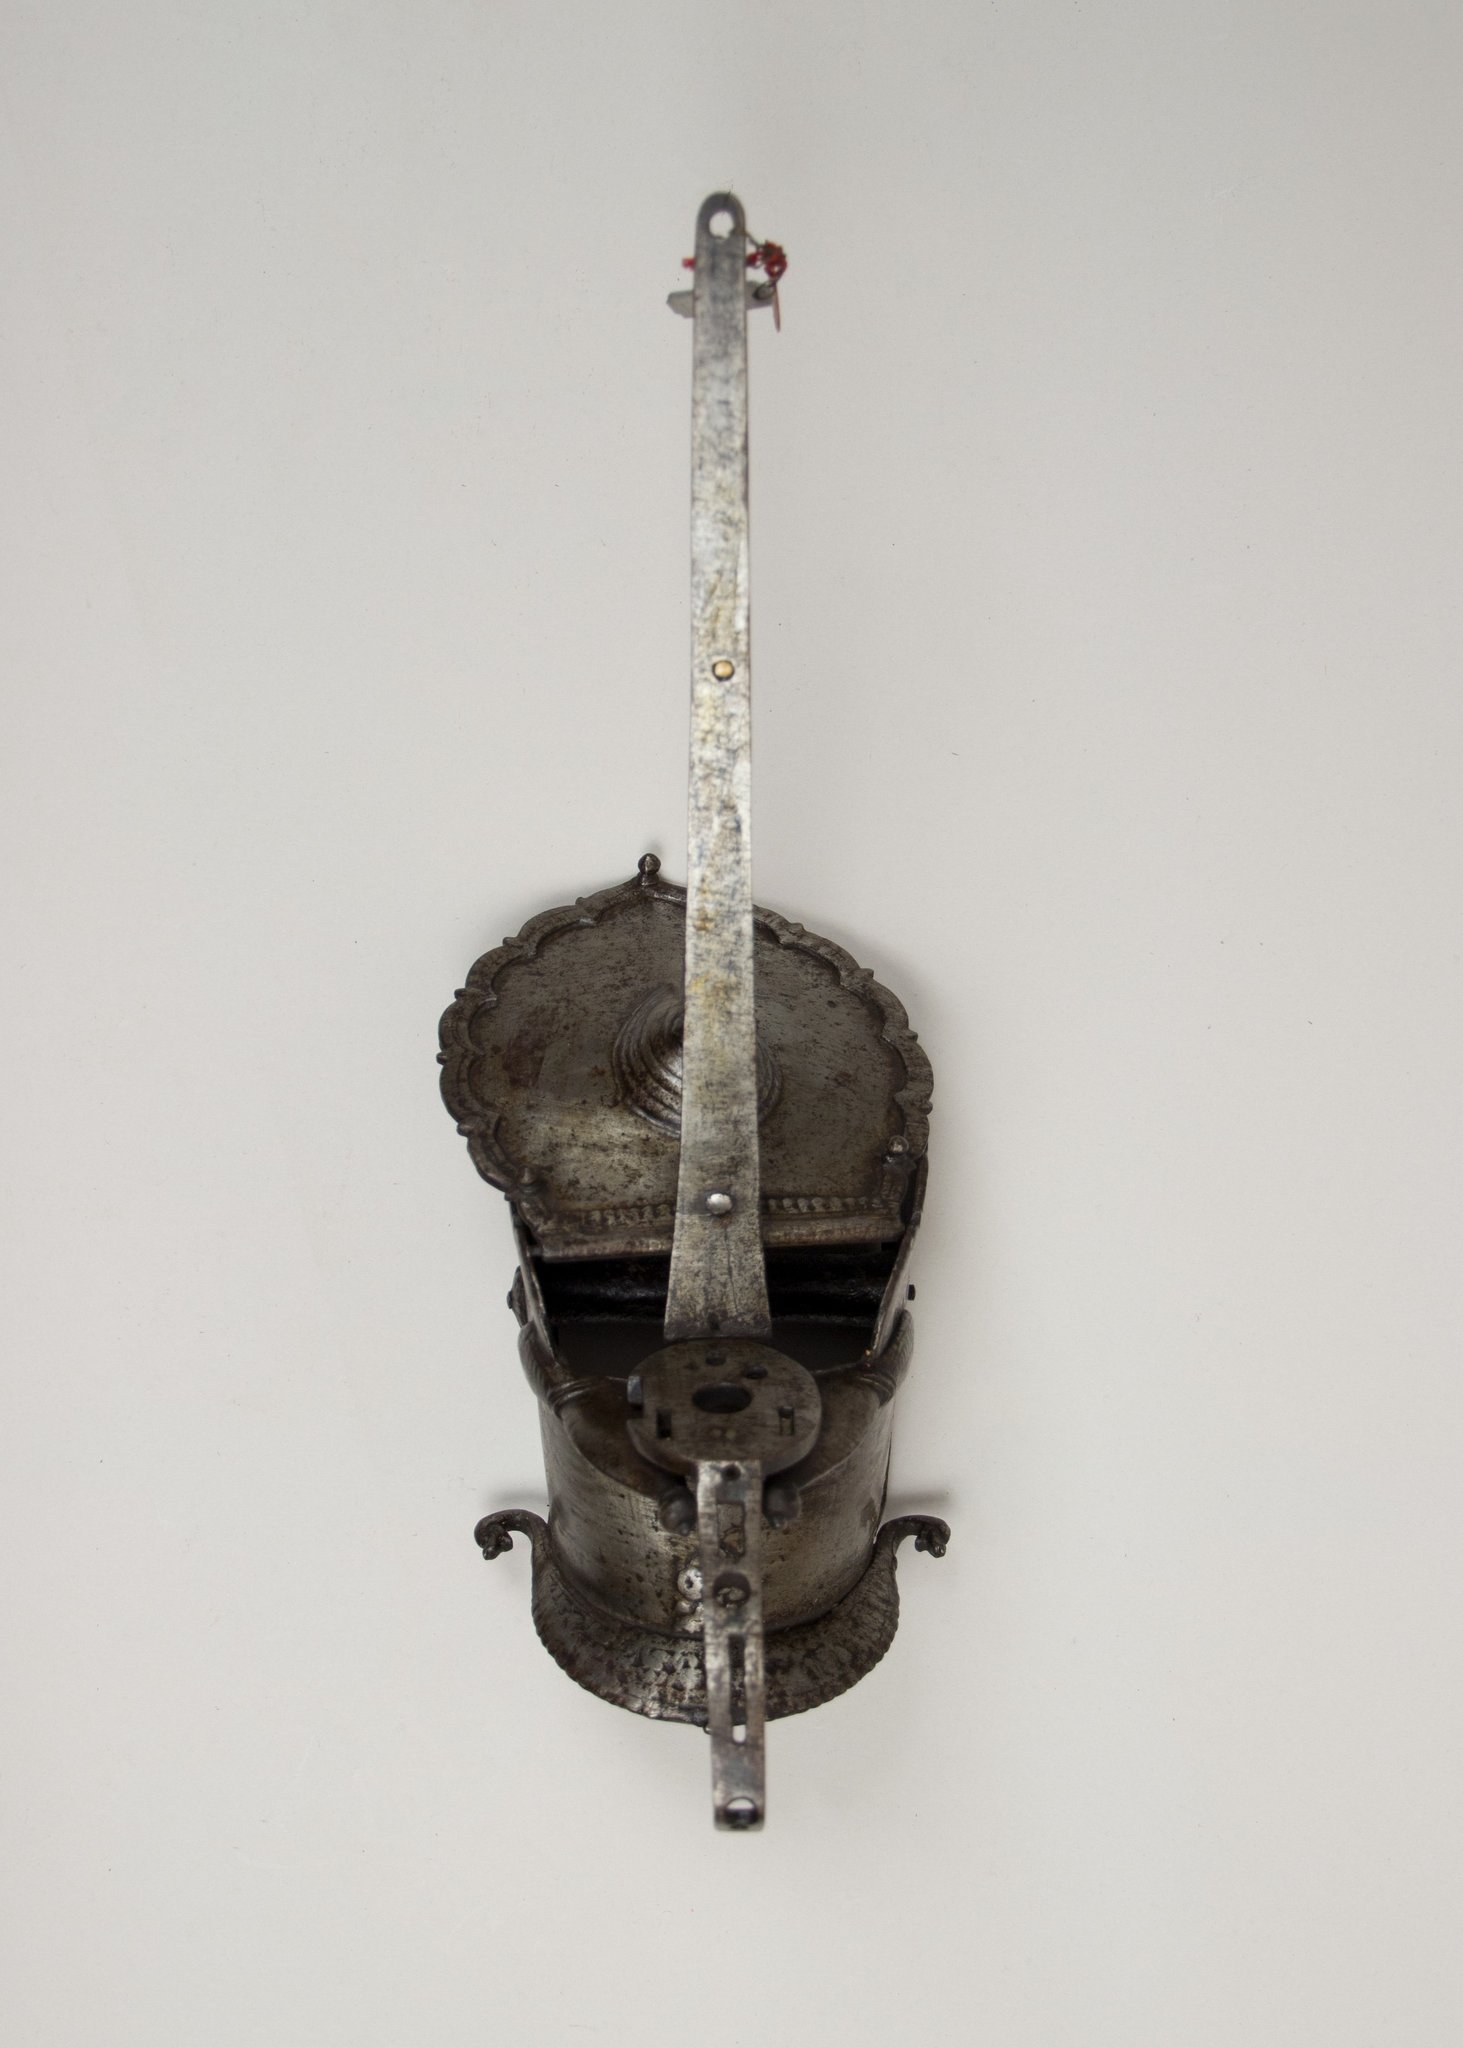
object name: hilt of a gauntlet sword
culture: indian, south indian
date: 1801-1900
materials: steel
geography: south india